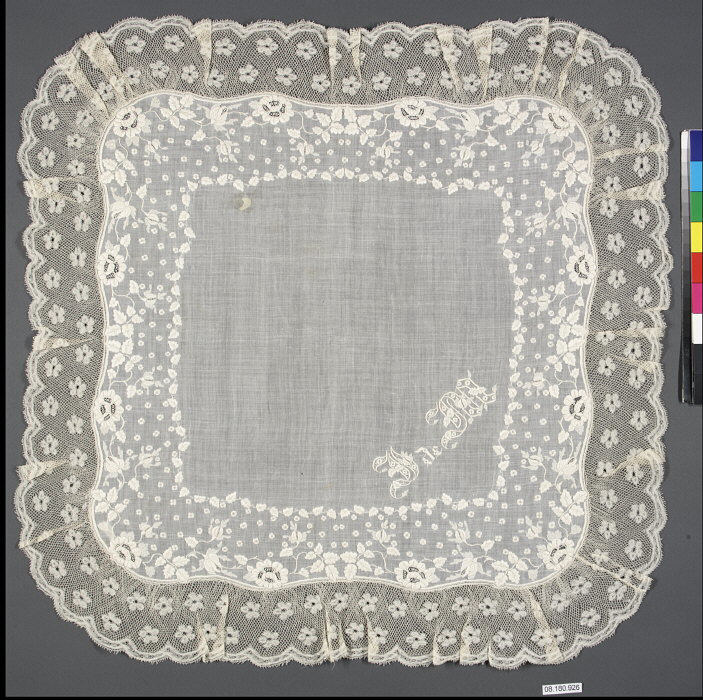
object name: handkerchief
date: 1801-1900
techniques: lace